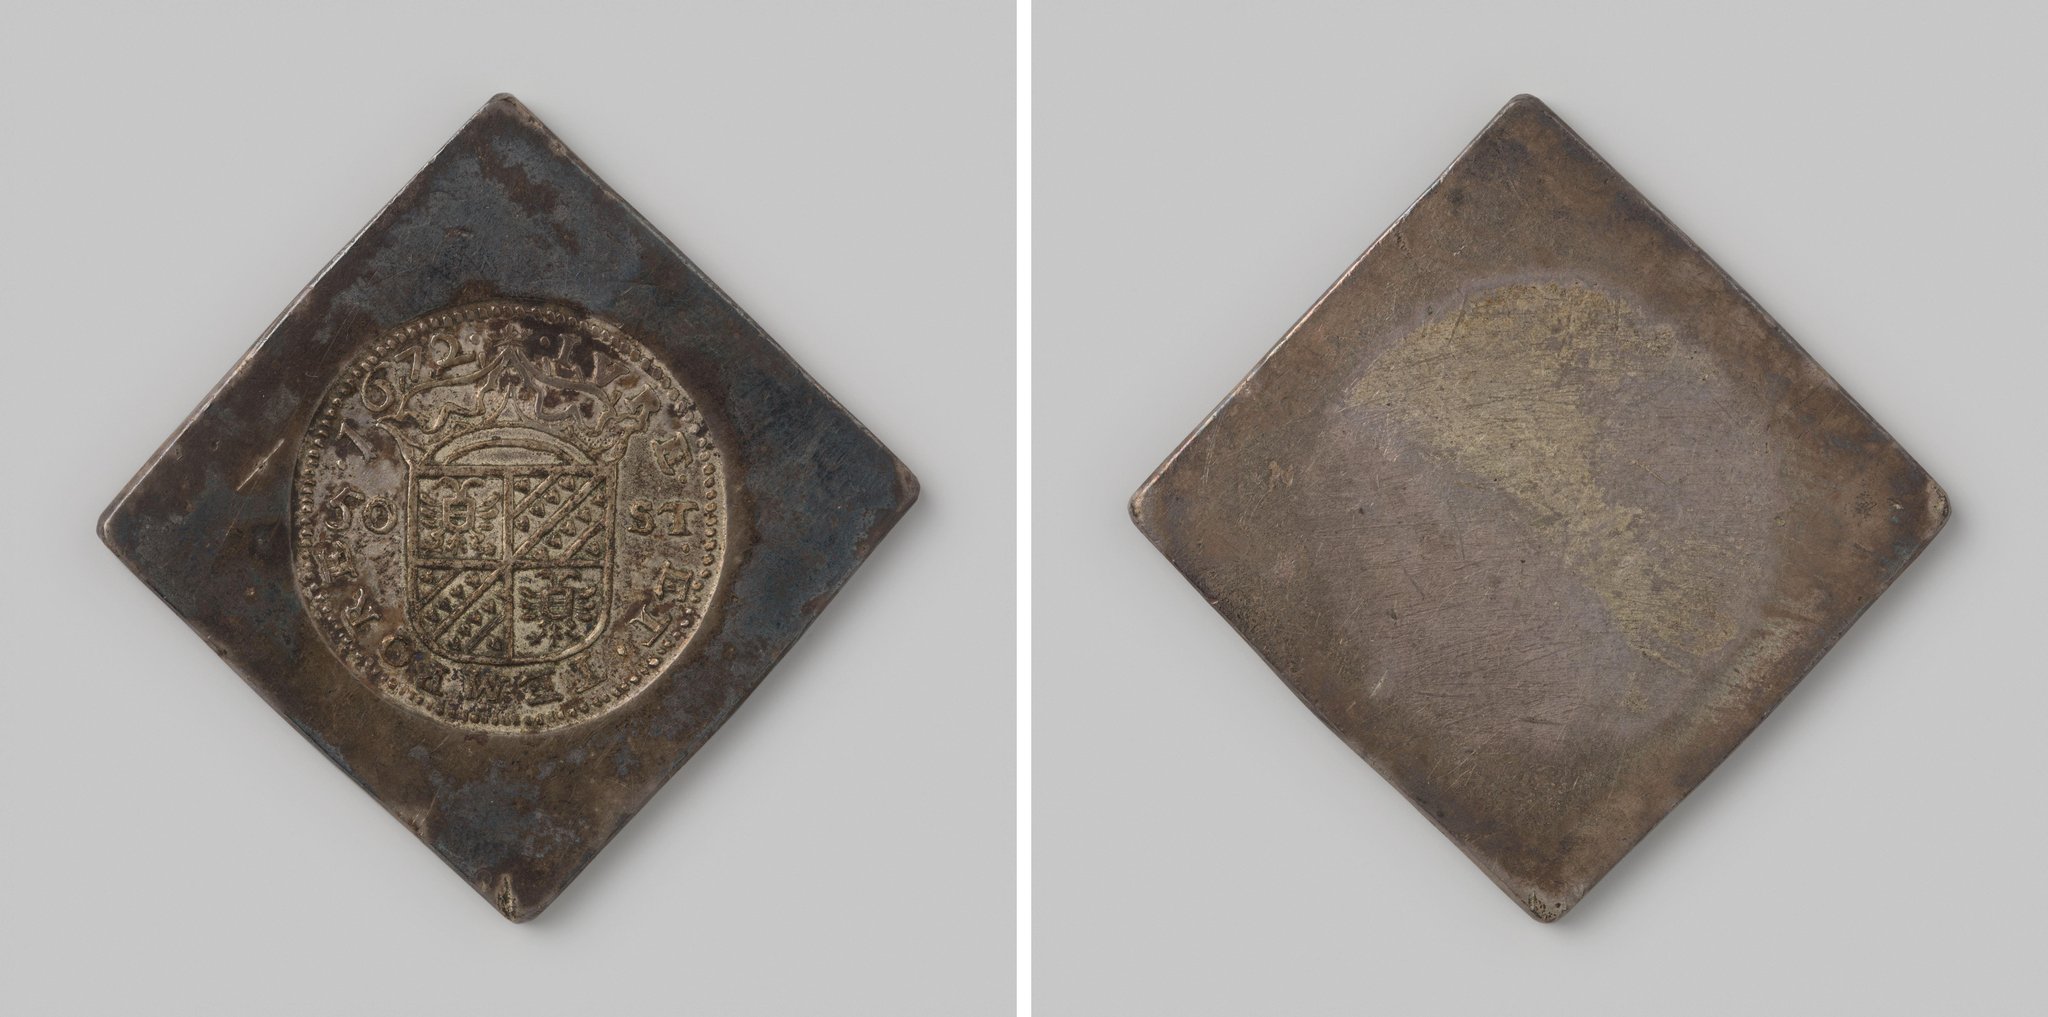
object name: thaler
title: daalder, noodmunt of herdenkingsmunt uit de stad Groningen, geslagen tijdens of na het beleg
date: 1672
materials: silver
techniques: striking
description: Zilveren vierkante noodmunt of herdenkingsmunt. Voorzijde: tussen waarde-aanduiding: 50 ST groot of klein gekroond samengesteld wapenschild van de stad en de Ommelanden. Jaartal in omschrift linksboven. Keerzijde: glad. In geval van klein wapenschild herdenkingsmunt.